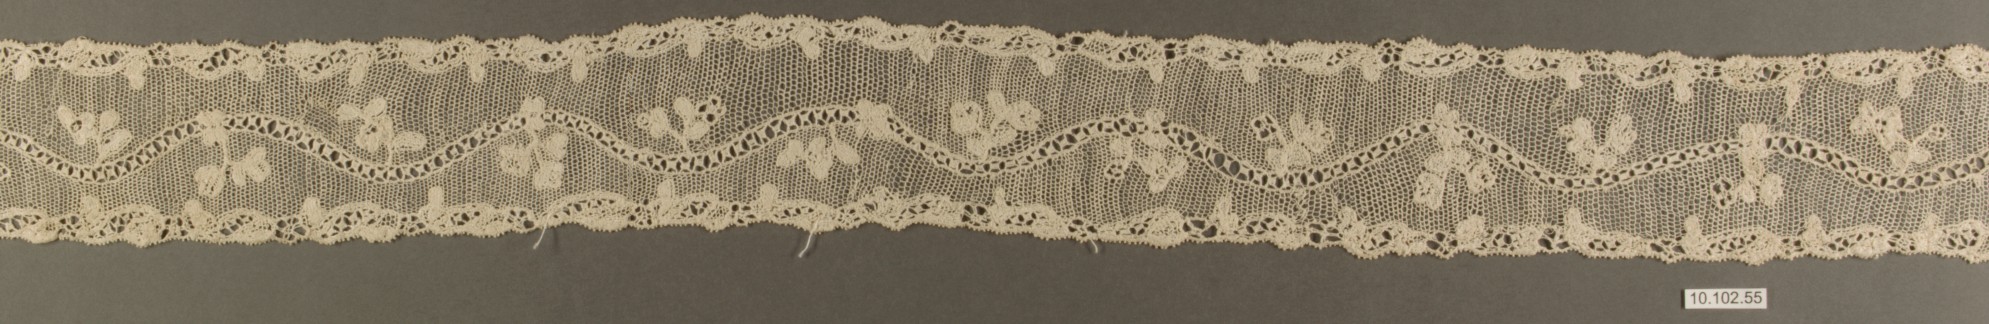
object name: barbe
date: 1701-1800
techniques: lace